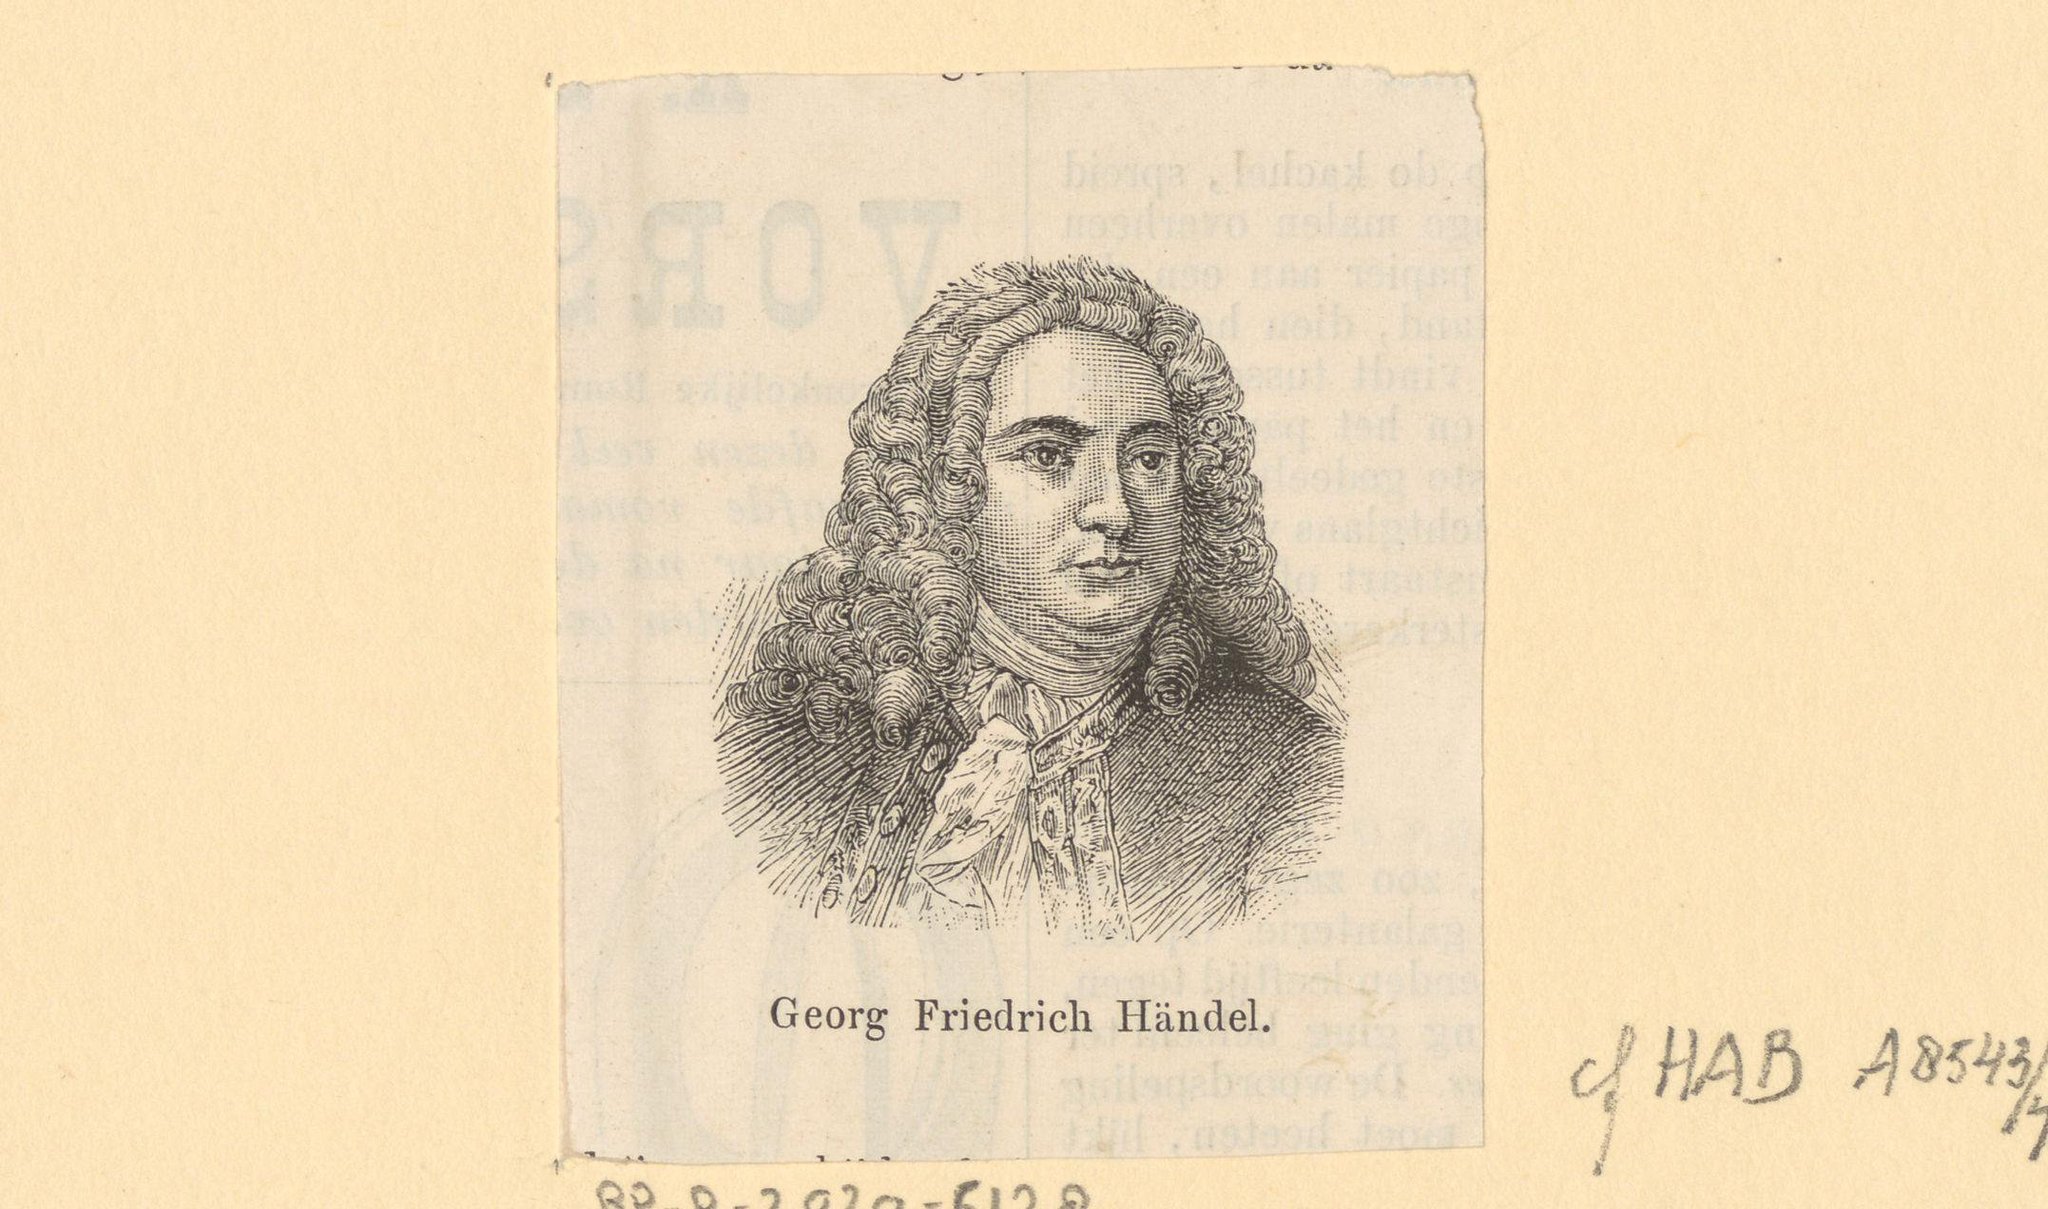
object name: print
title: Portret van Georg Friedrich Händel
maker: Anonymous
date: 1850-1899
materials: paper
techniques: letterpress printing, engraving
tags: historical persons, portrait of composer